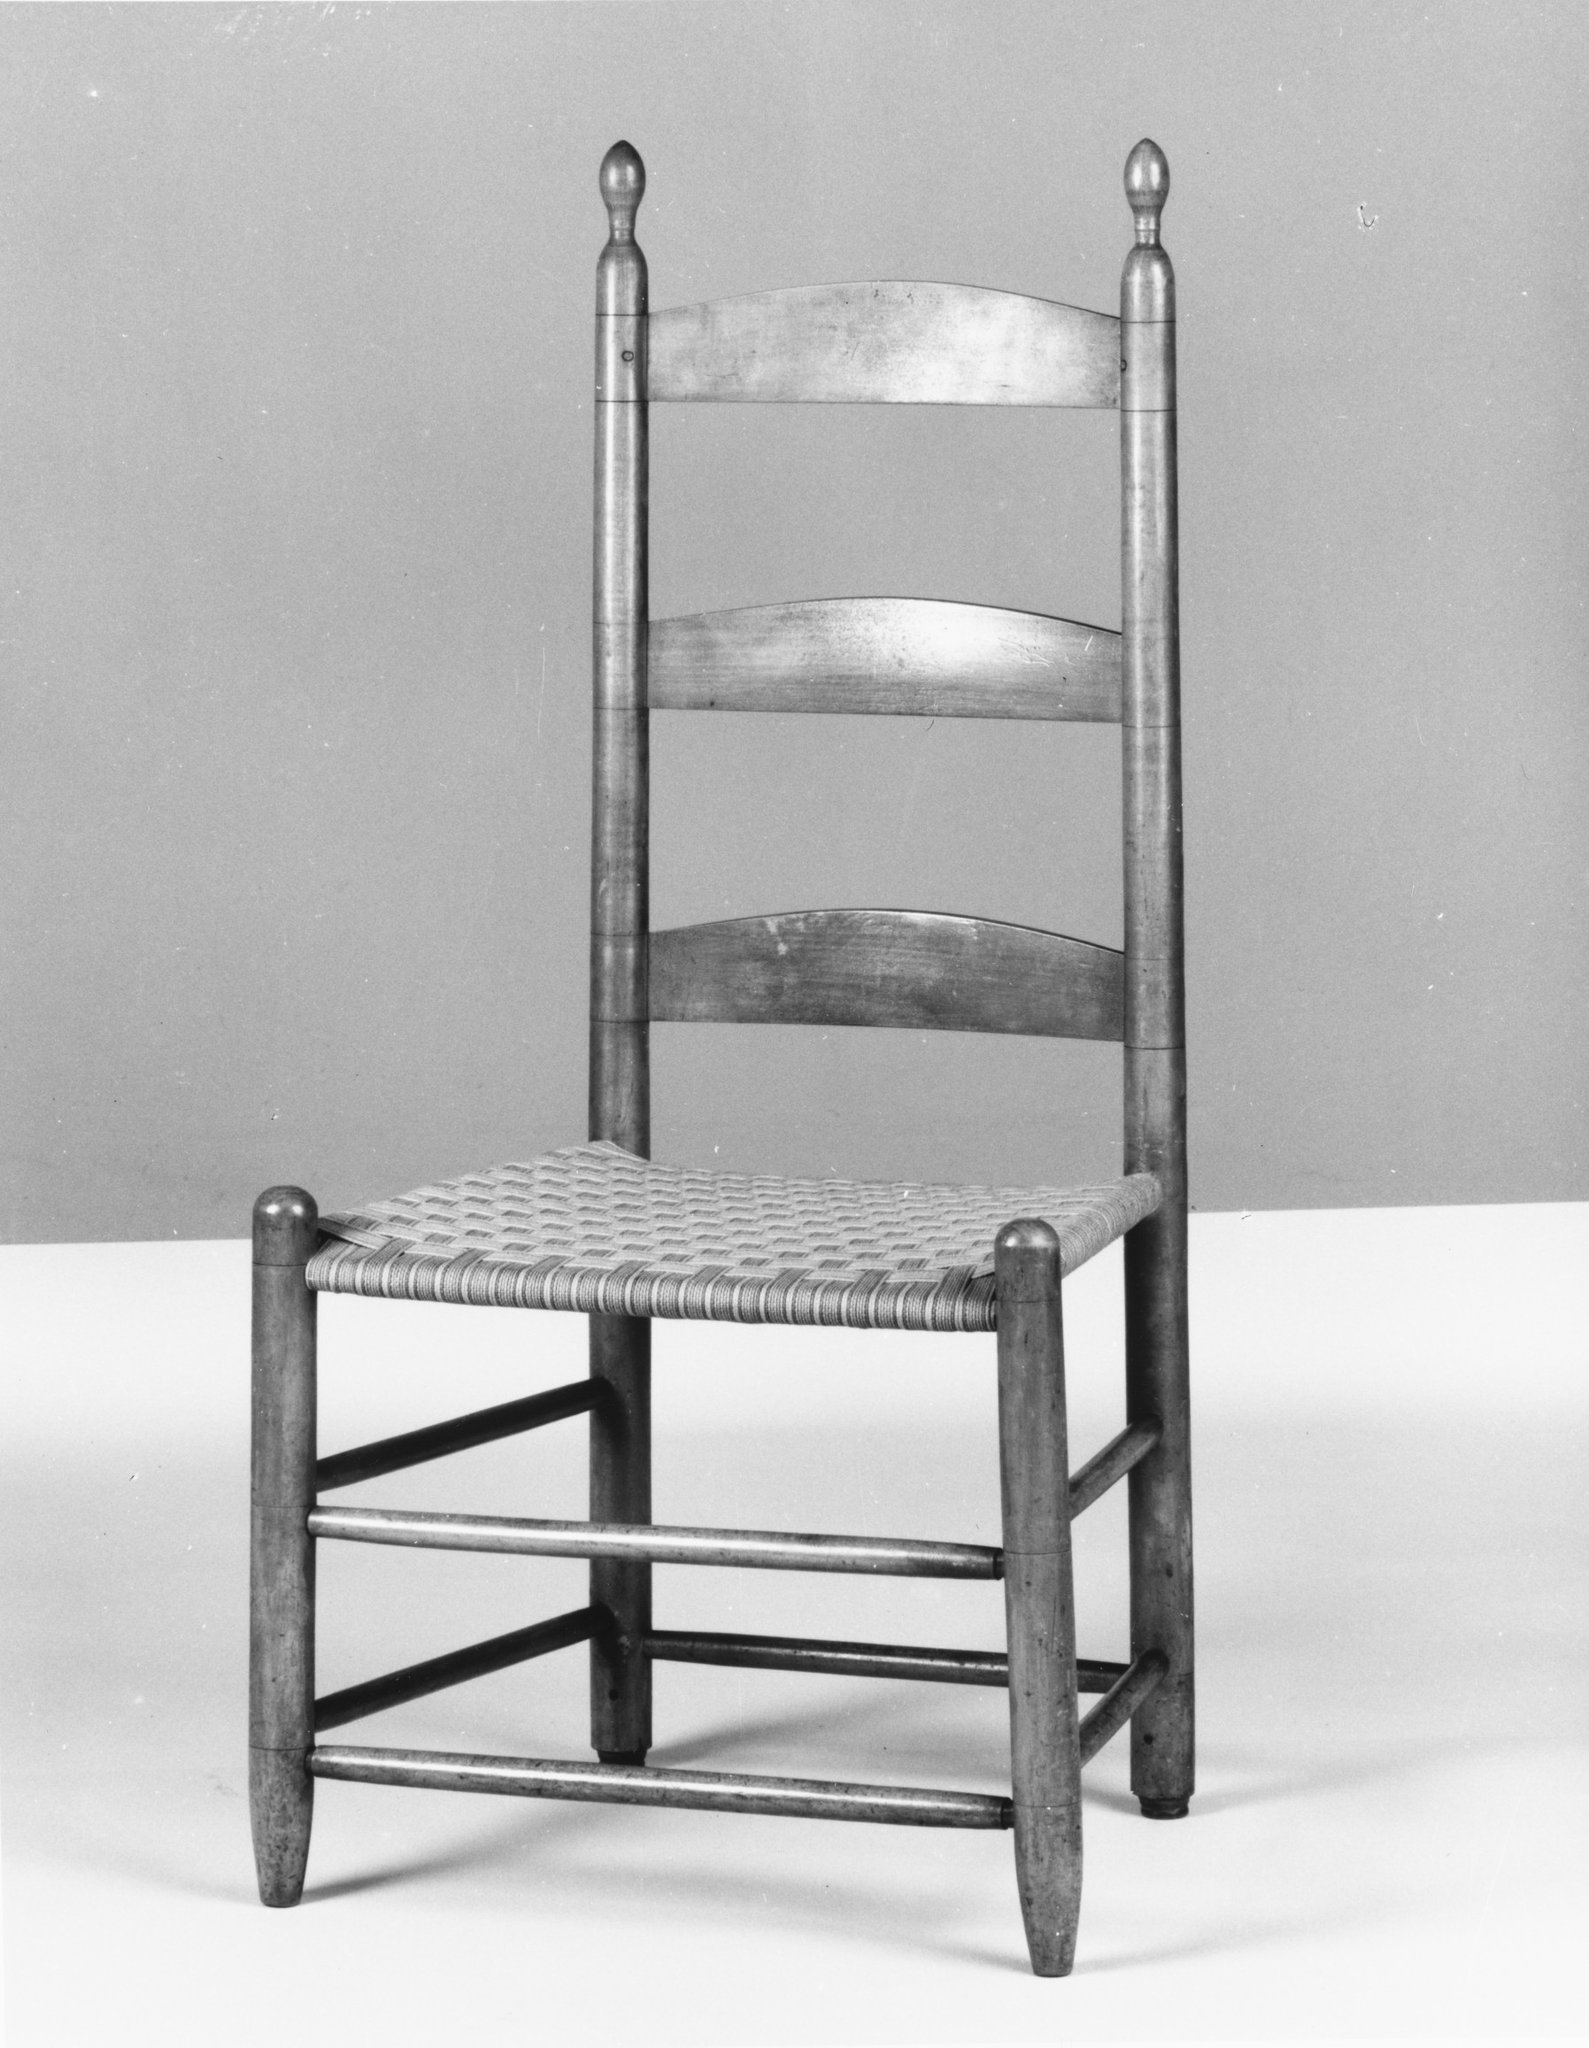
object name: side chair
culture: american, shaker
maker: united society of believers in christ’s second appearing (“shakers”)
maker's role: maker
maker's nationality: american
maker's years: 1750-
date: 1830-1850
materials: wood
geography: united states